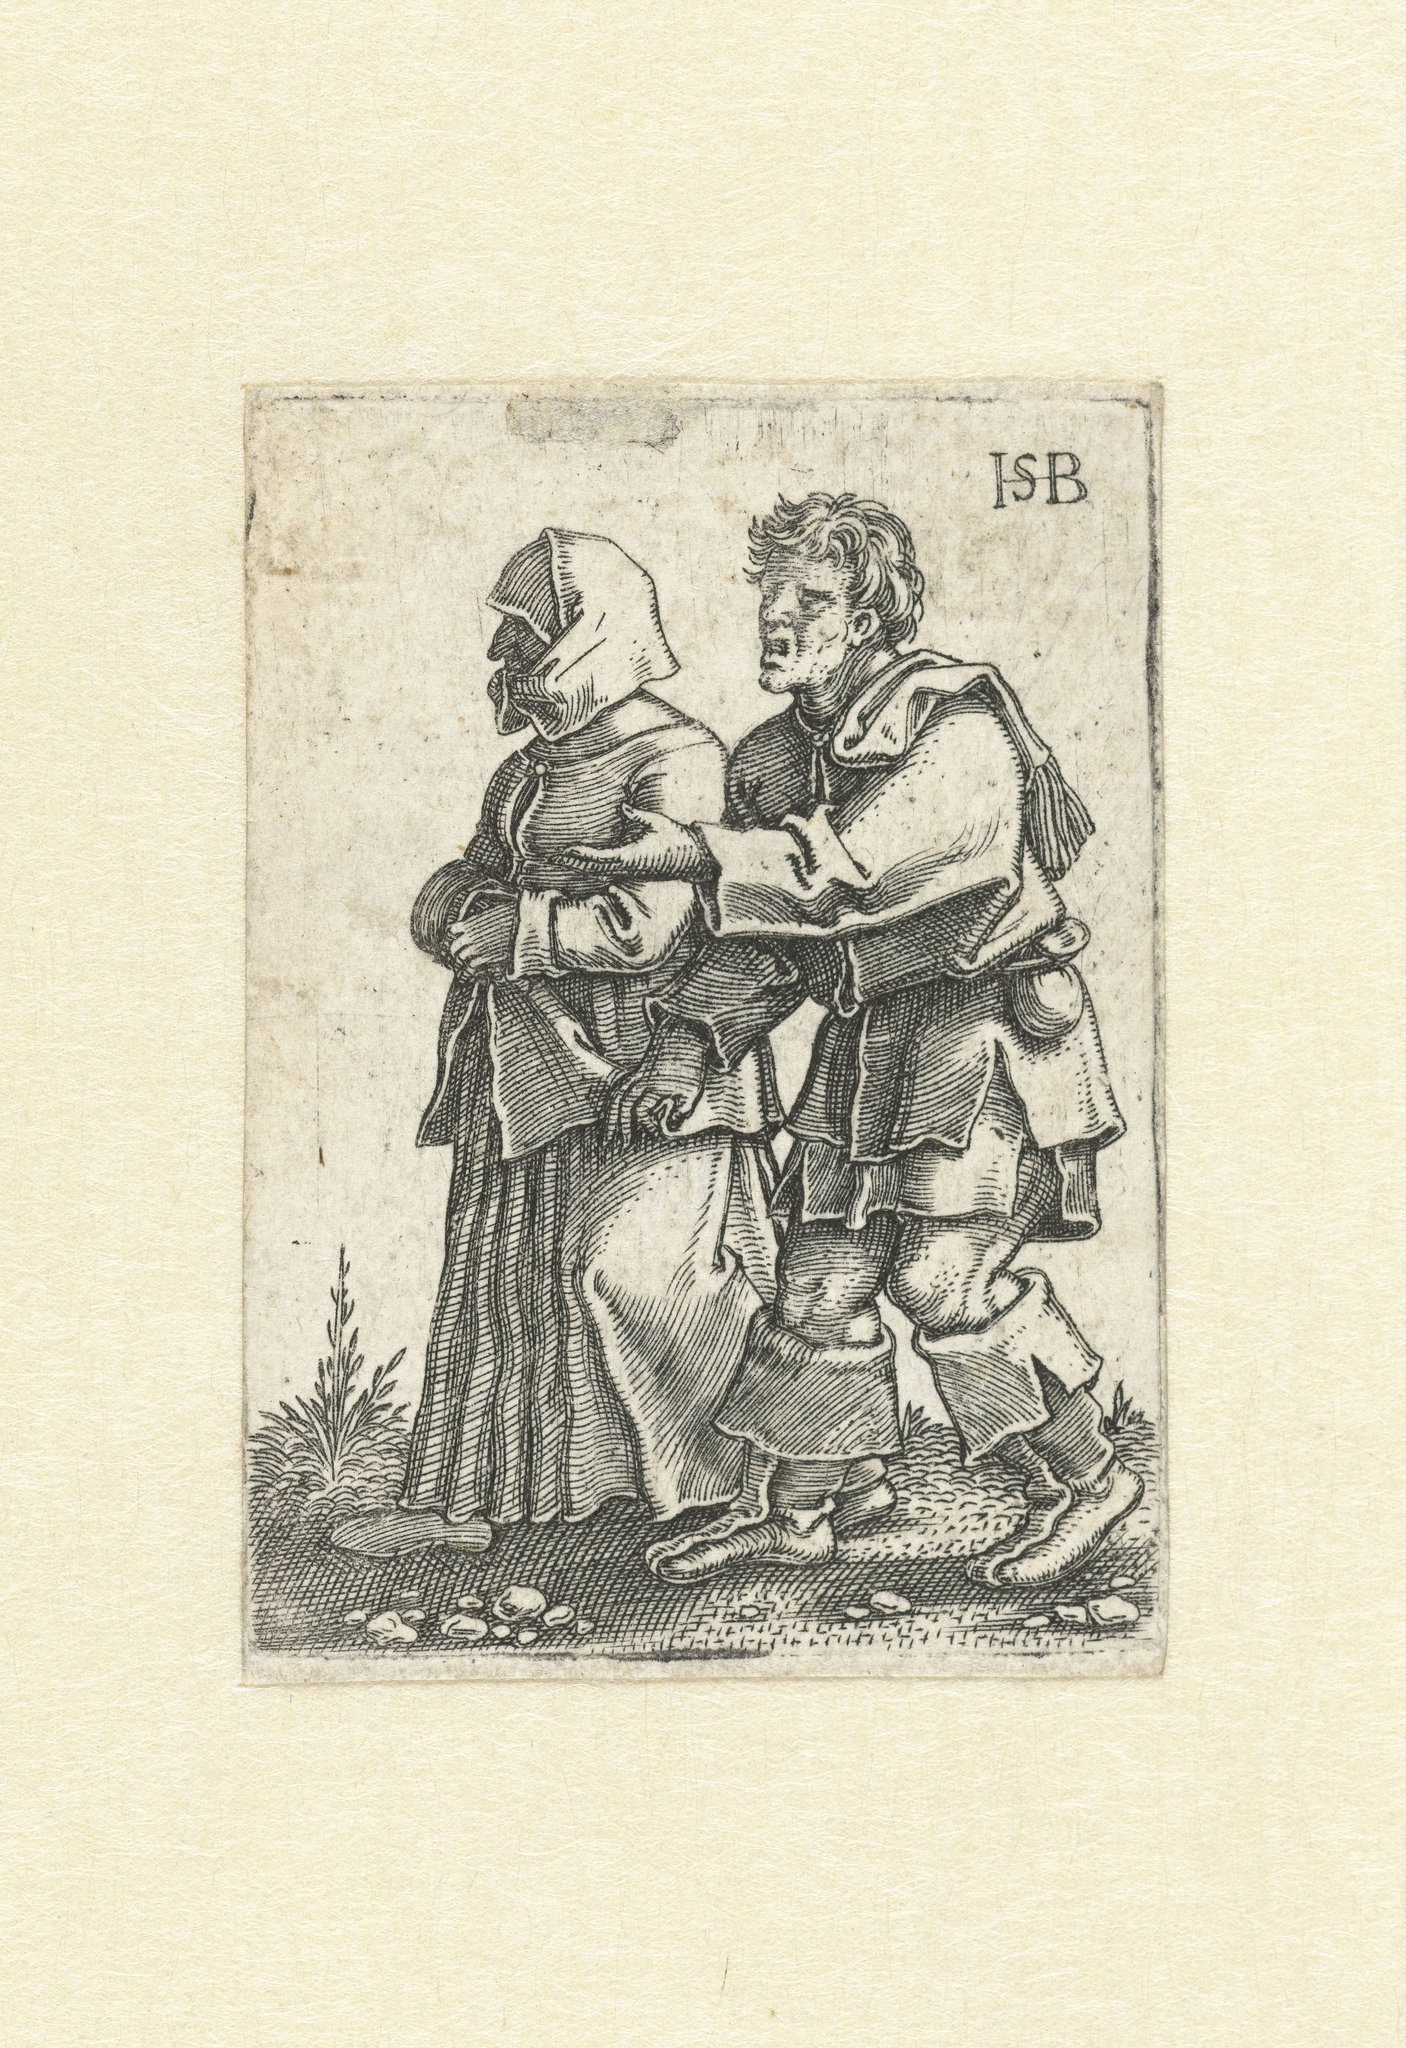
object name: print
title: Optocht voor boerenbruiloft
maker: hans sebald beham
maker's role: designer, draughtsman, print maker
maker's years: 1500-1550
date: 1510-1550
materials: paper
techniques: engraving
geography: germany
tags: farmers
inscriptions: collector's mark: Lugt 2233